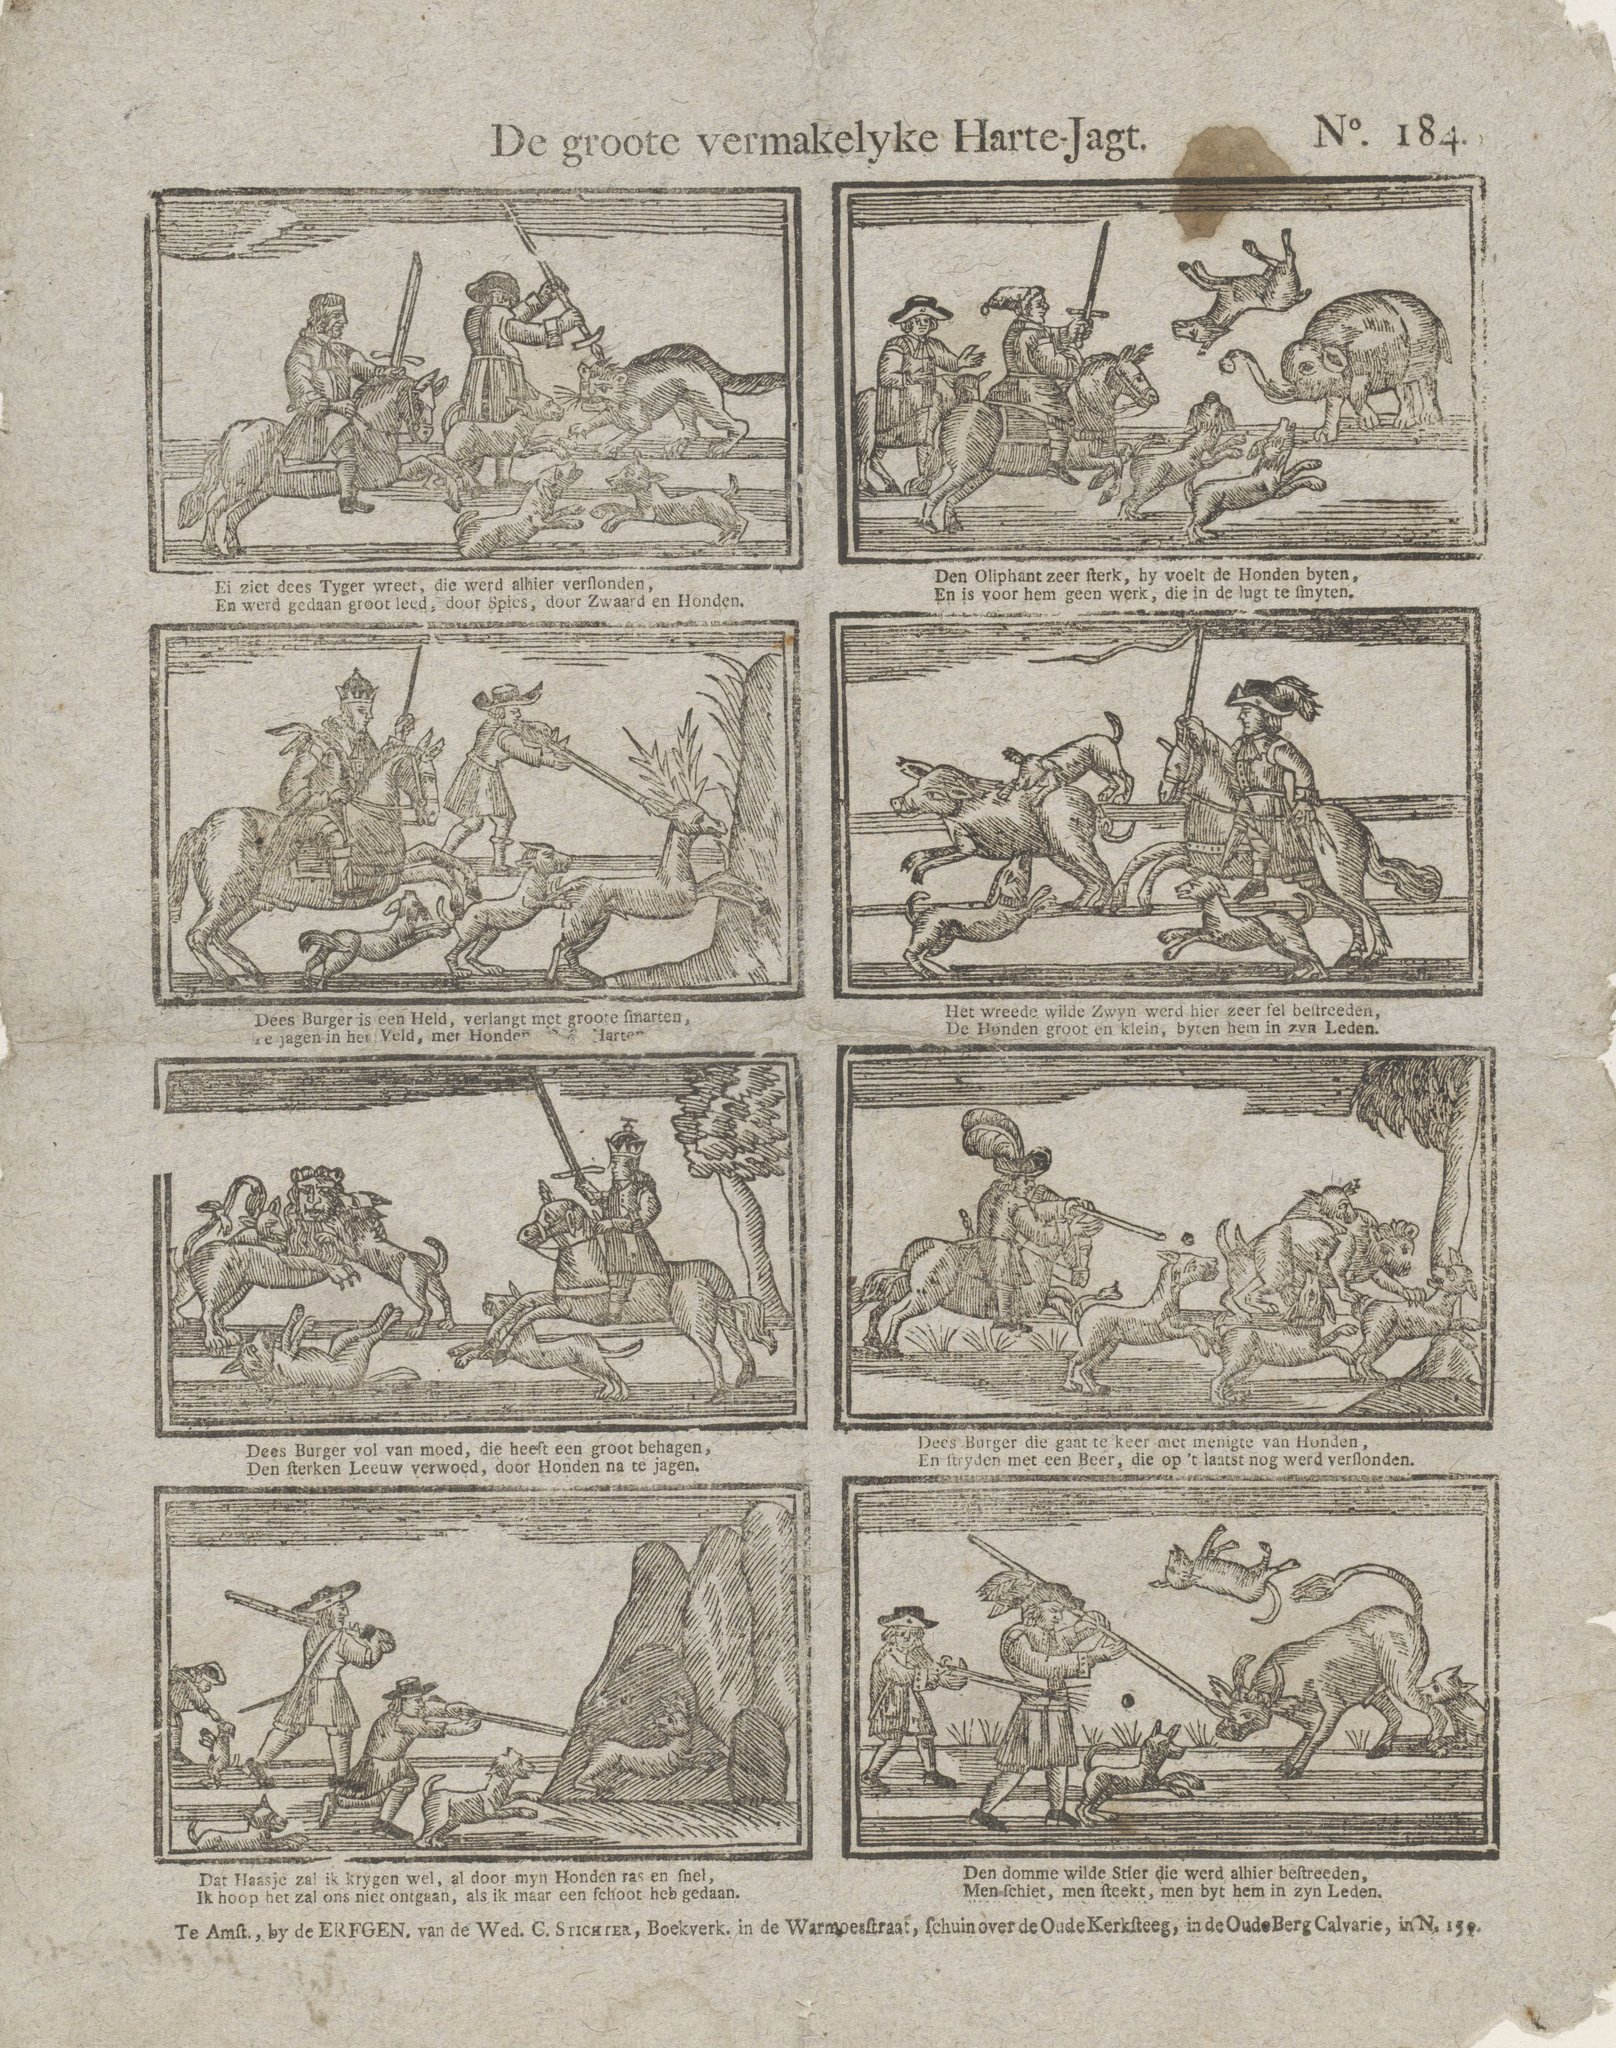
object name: popular print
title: De groote vermakelyke harte-jagt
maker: Anonymous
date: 1715-1813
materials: paper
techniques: letterpress printing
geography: amsterdam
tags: hunter, hunters hunting (n.b.: in 1988-1990 this notation denoted the concept of 43c11421 'hunters resting during the hunt')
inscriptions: inscription: ‘Adje Pieters 1813’, collector's mark: Lugt 2228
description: Blad met 8 jachttaferelen. Onder elke afbeelding een tweeregelig onderschrift. Genummerd rechtsboven: No. 184.